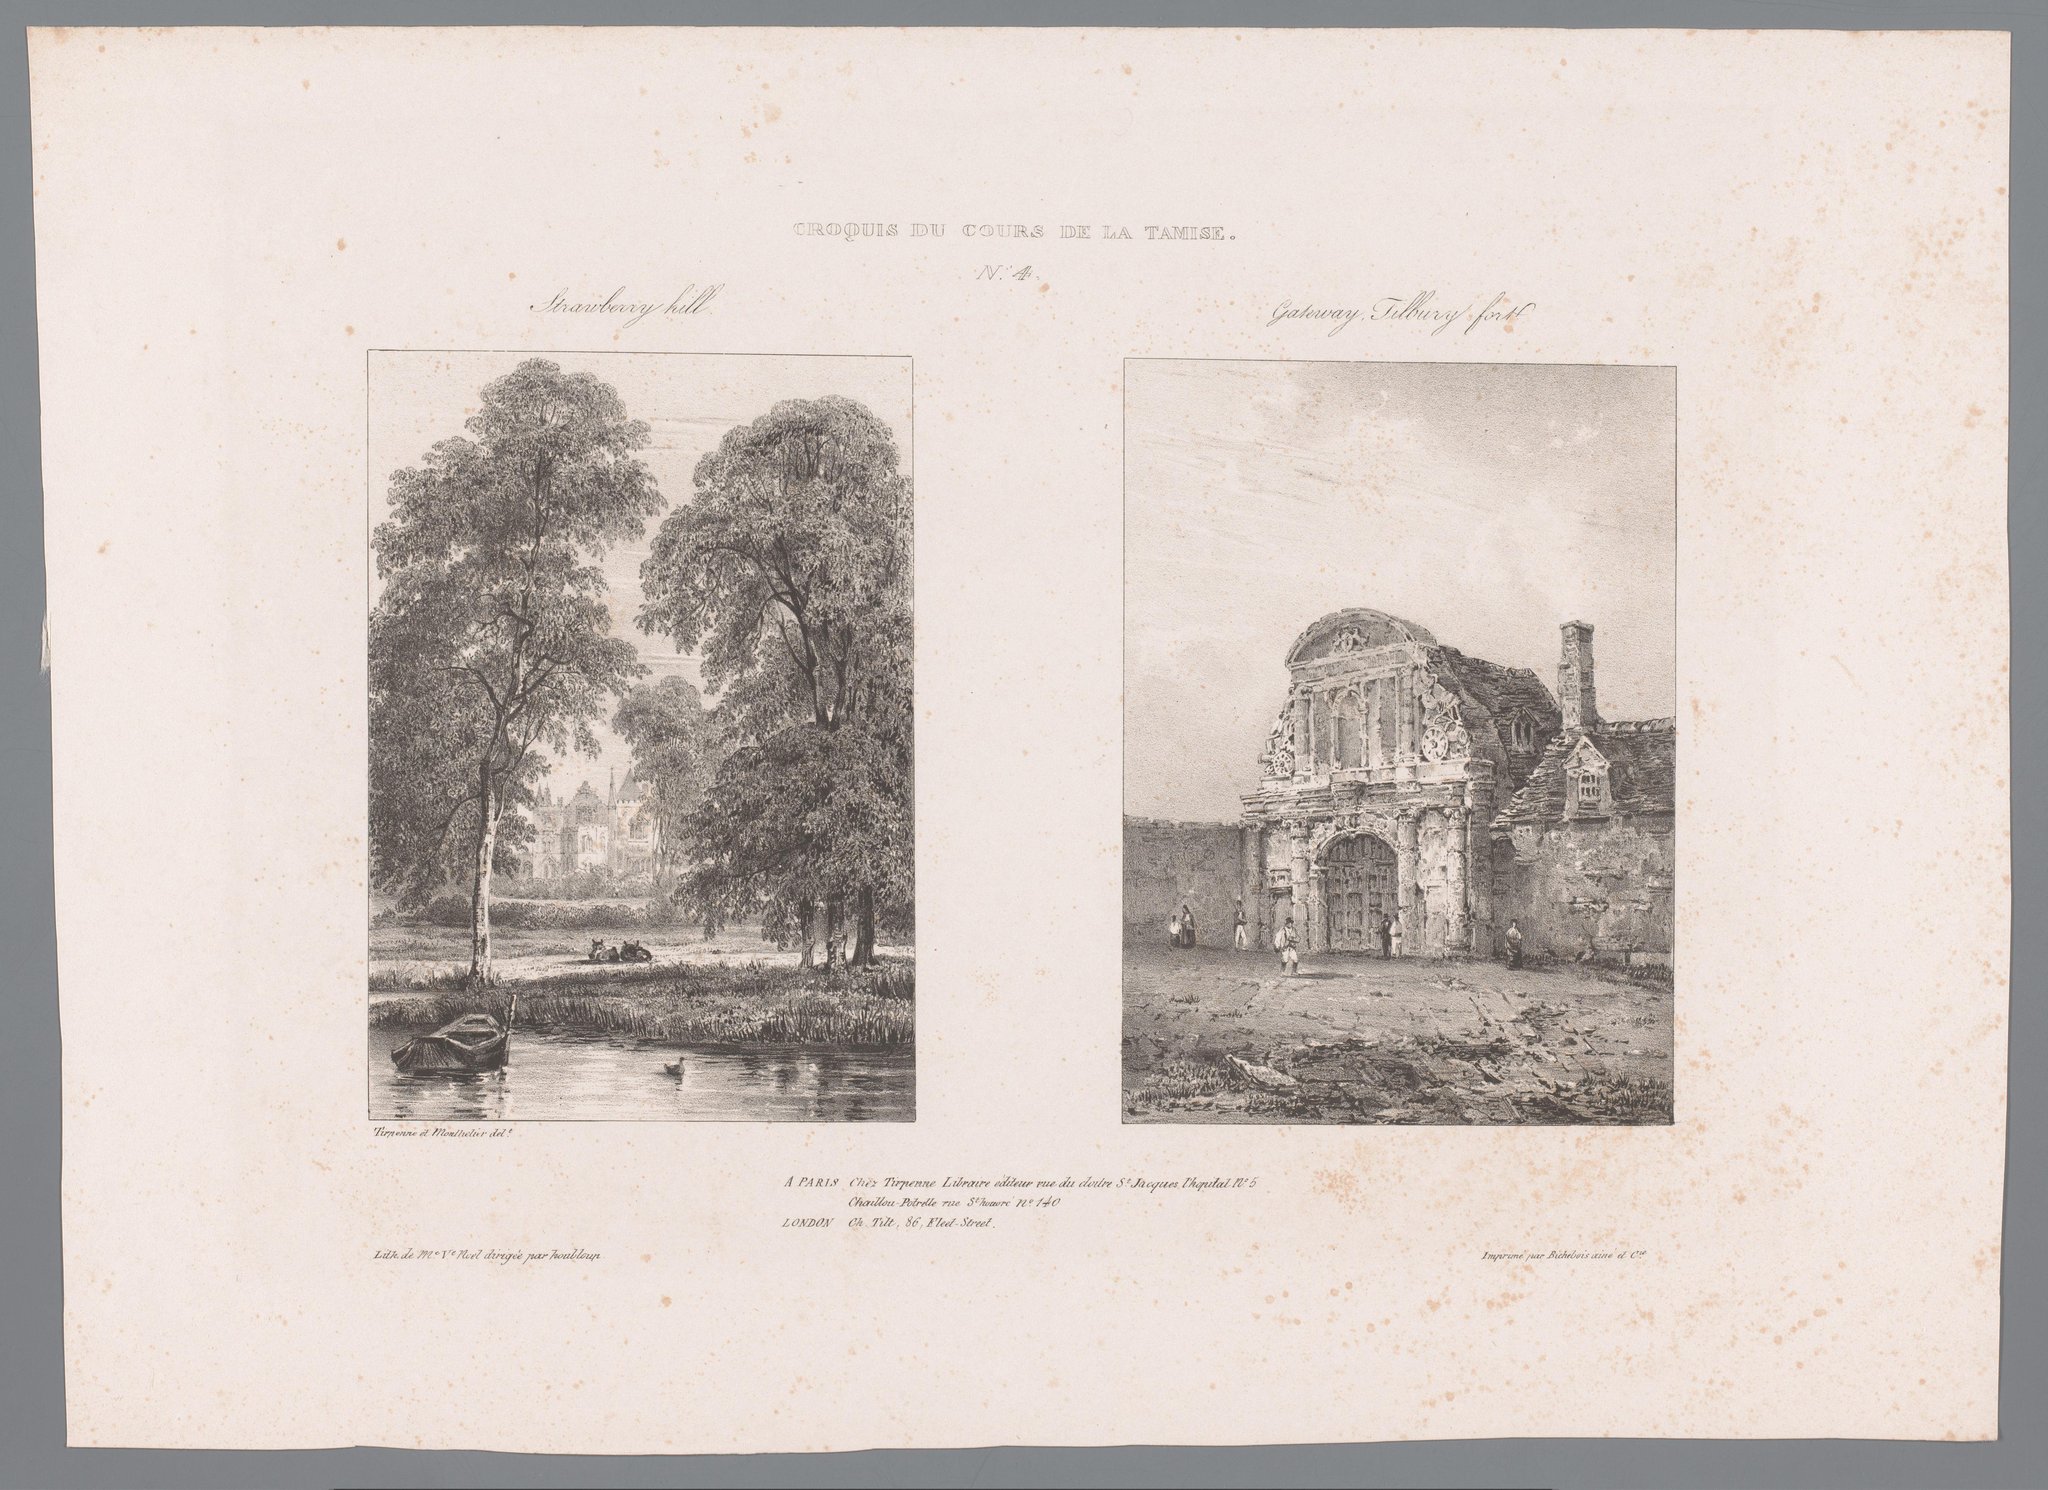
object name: print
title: Gezicht op Strawberry Hill en gezicht op de toegangspoort van Tilbury Fort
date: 1830-1831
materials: paper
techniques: lithograph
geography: paris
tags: river, gate, entrance, villa, thames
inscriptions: collector's mark: Lugt 2228